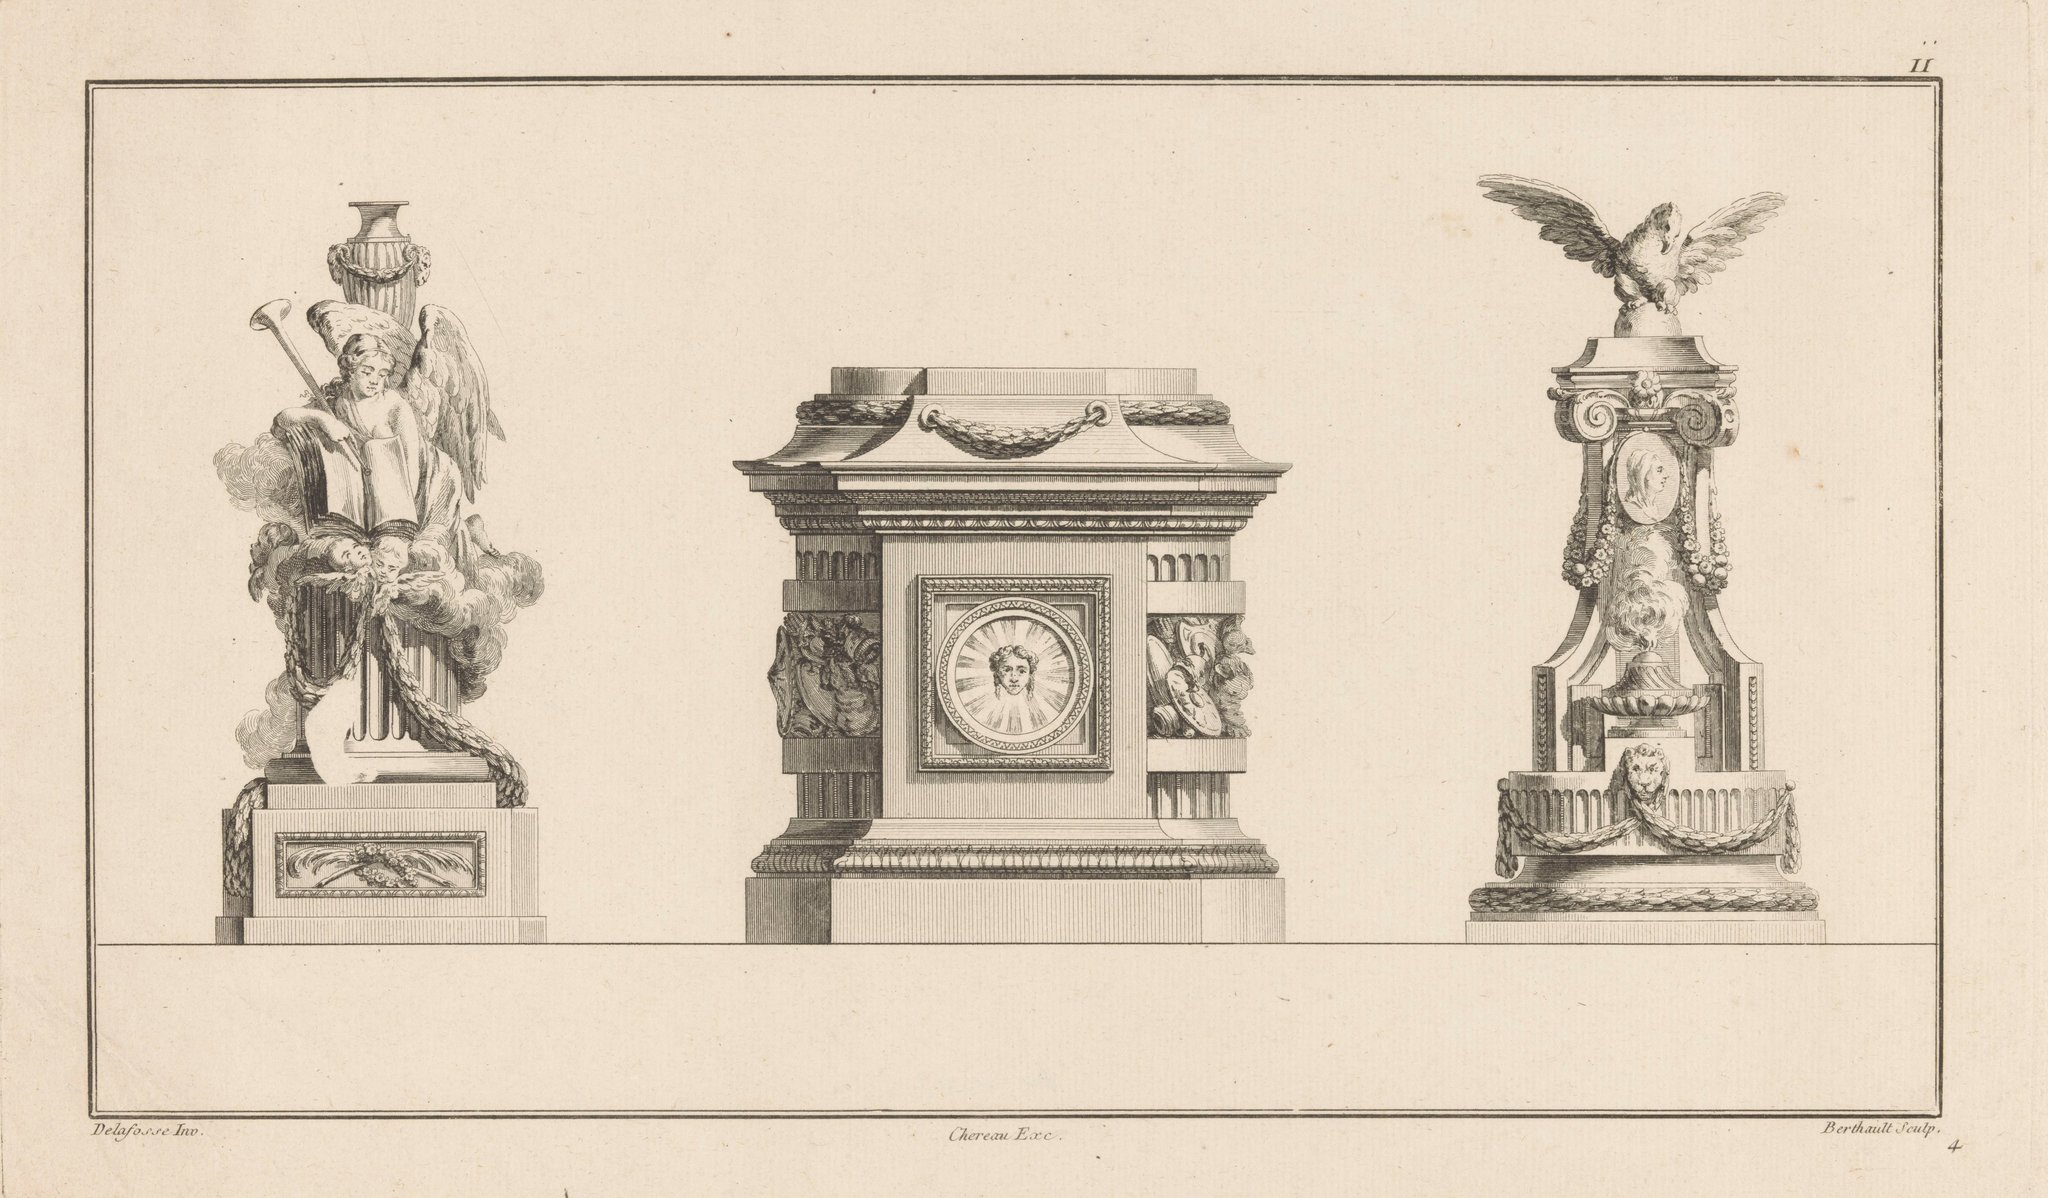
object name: print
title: IIe Volume De l'Oeuvre de J. Ch. Delafosse (...)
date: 1771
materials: paper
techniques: engraving, etching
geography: paris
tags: pedestal of a piece of sculpture (perhaps in the form of a herm), monument, statue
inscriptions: collector's mark: Lugt 2760, collector's mark: Lugt 2228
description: Links een monument met een engel met boek en bazuin. In het midden een voetstuk met medaillon met een gezicht in stralenkrans. Rechts een monument met een rookvat, een medaillon en een adelaar op een globe.